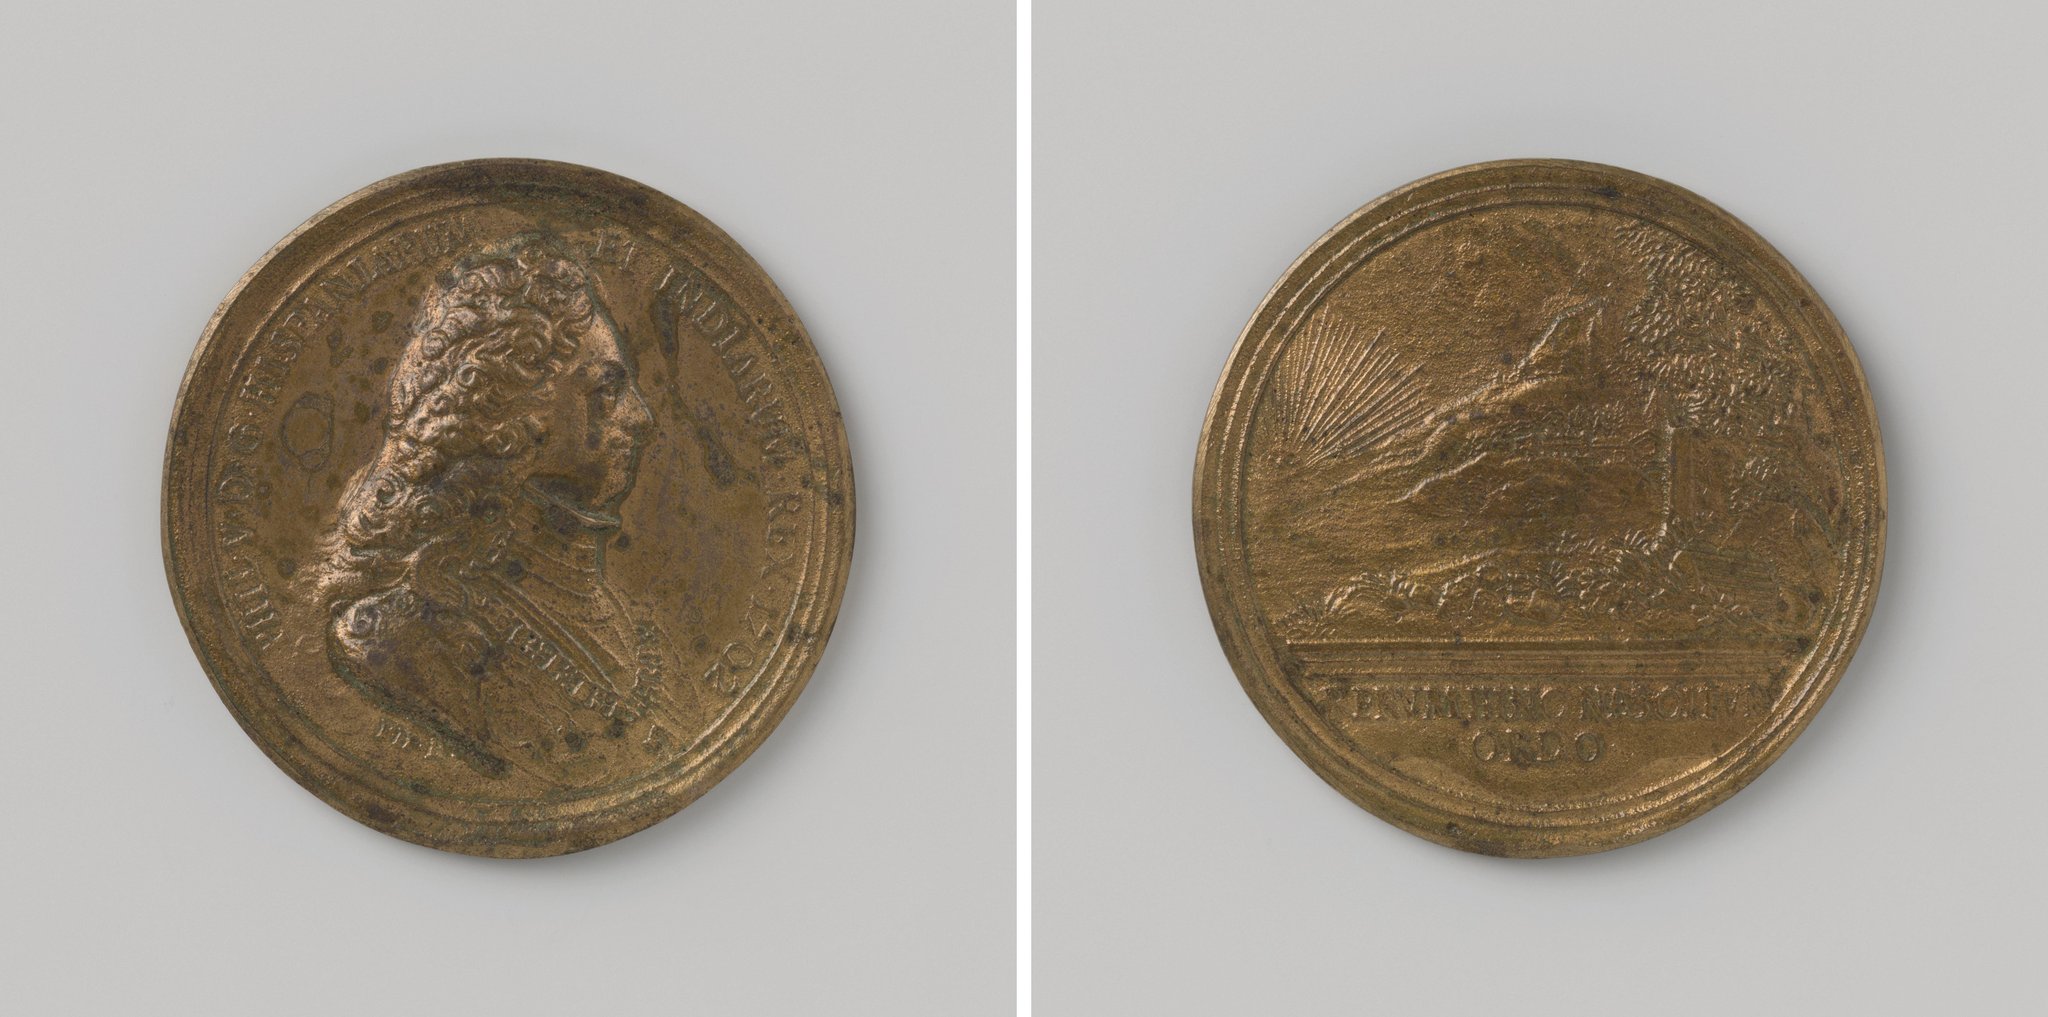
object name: history medal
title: Inhuldiging van Filips V te Brussel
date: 1702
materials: copper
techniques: striking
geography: antwerp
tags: filips v (koning van spanje), brussels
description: Koperen penning. Voorzijde: borststuk man binnen omschrift. Keerzijde: opkomende zon beschijnt berglandschap; afsnede: opschrift